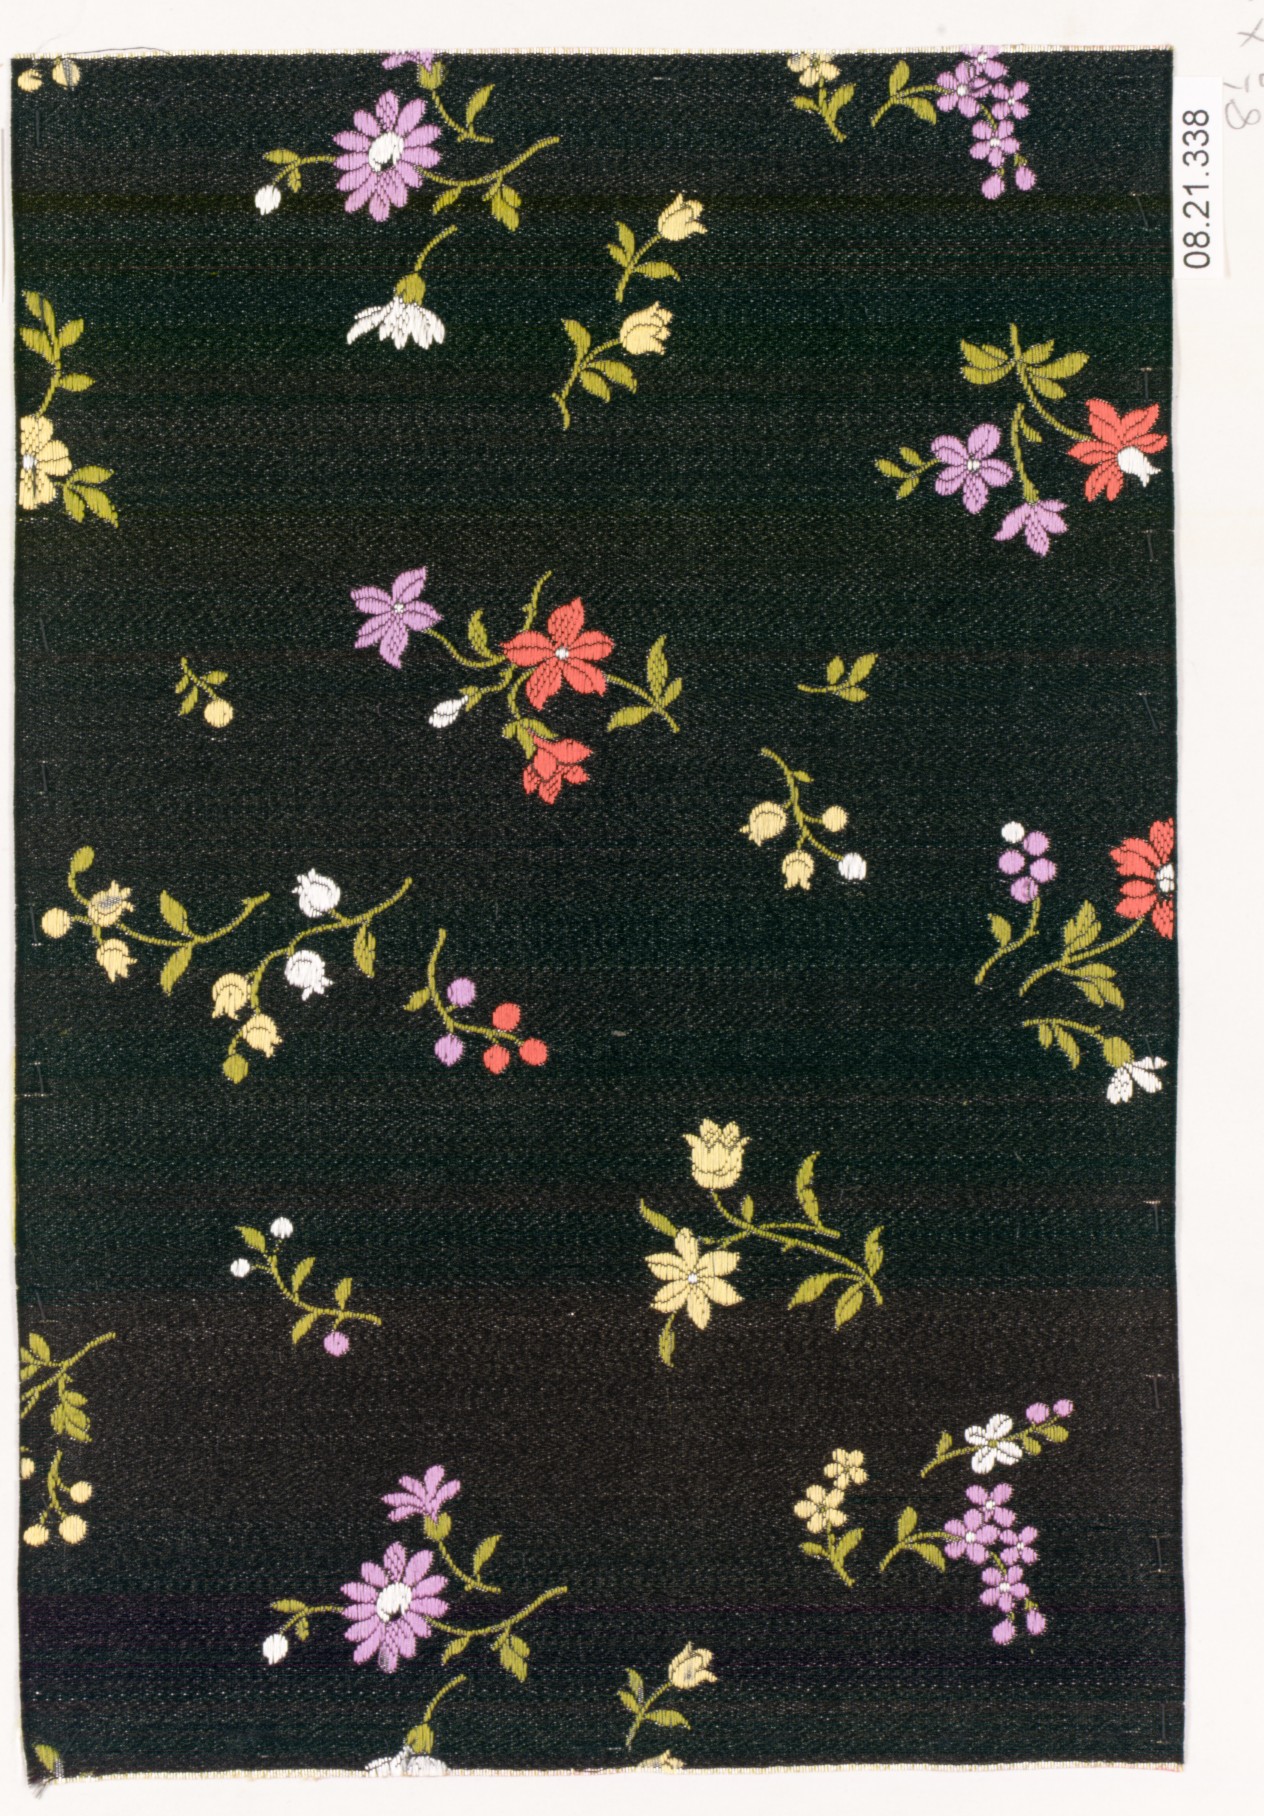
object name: textile sample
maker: Anonymous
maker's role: designer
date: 1900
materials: silk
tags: flowers